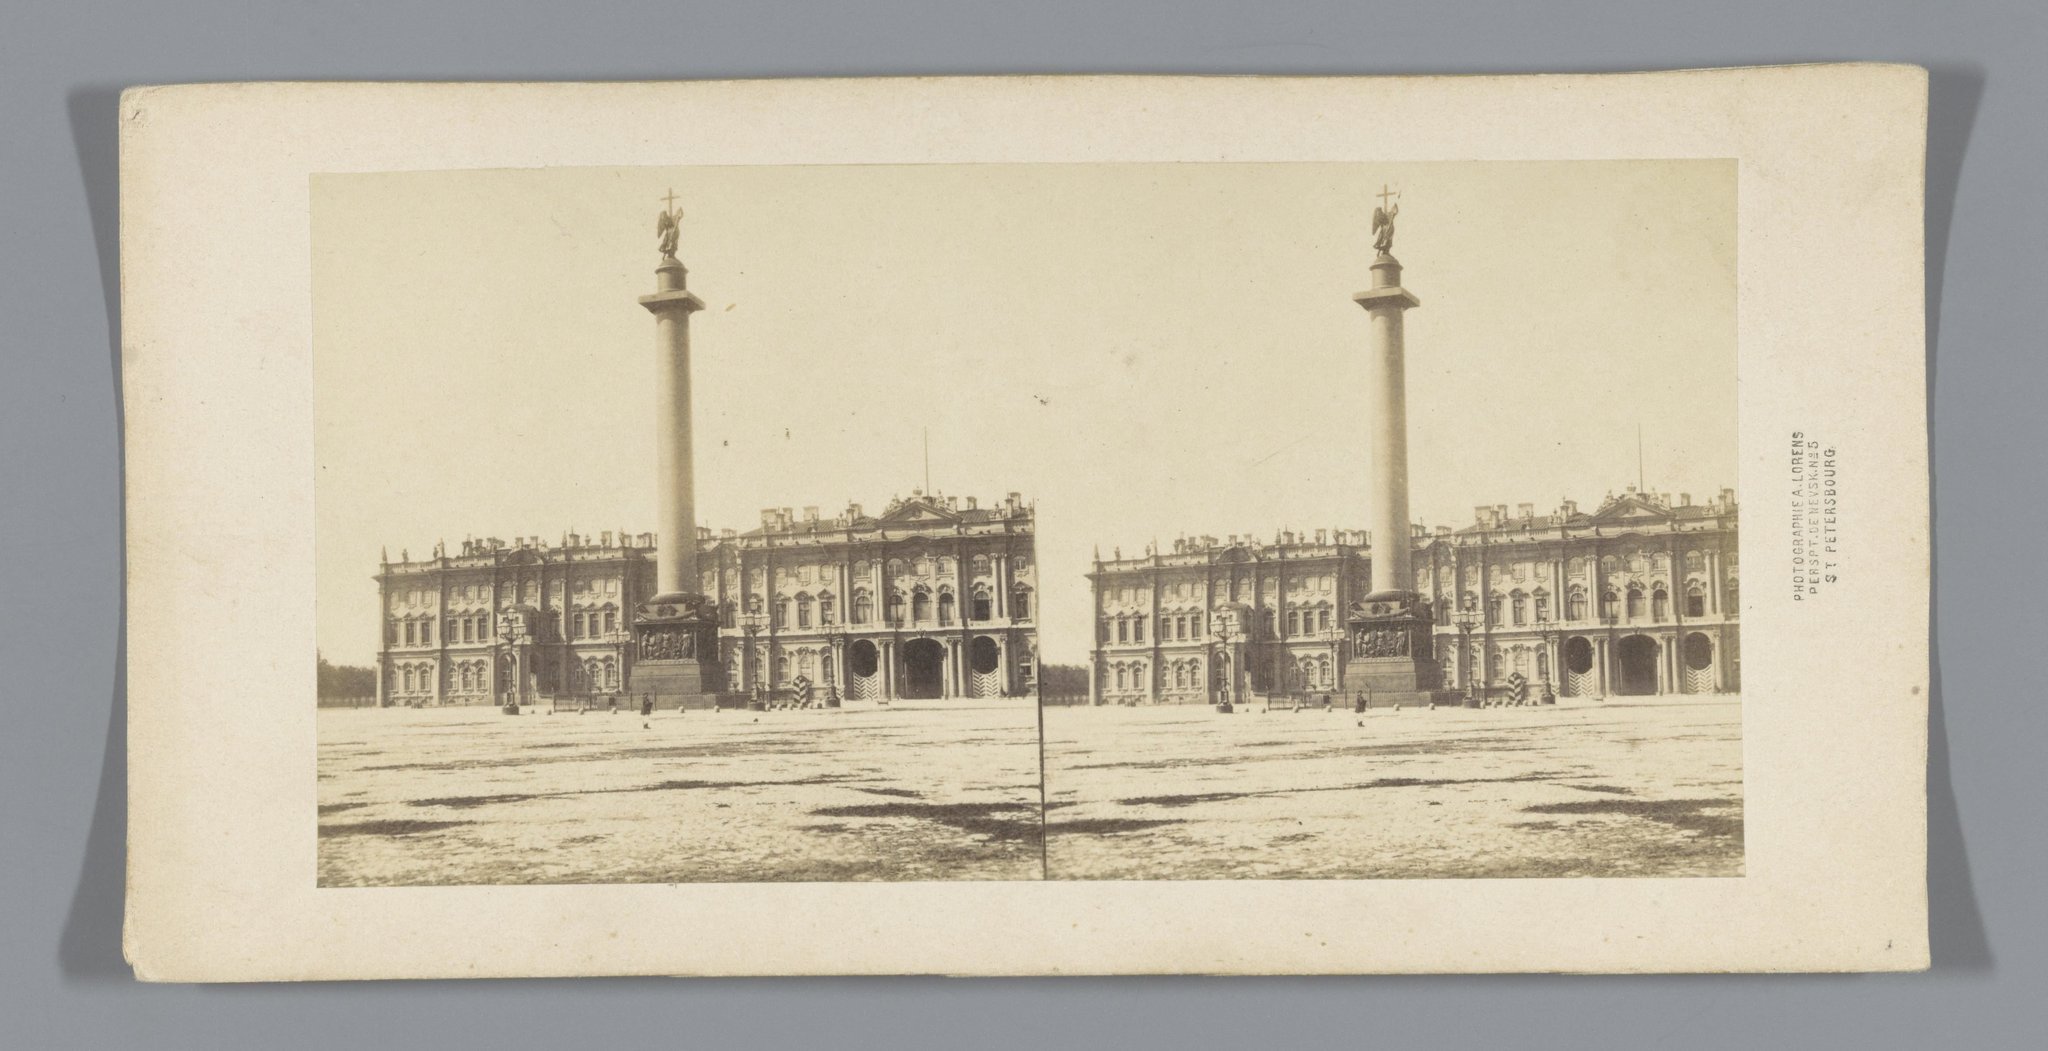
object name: stereograph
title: Gezicht op het Winterpaleis en de Alexander-obelisk in Sint-Petersburg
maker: alfred lorens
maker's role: fotograaf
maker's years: 1830-1896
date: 1860-1880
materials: cardboard, photographic support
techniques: albumen print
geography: sint-petersburg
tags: palace, monument, statue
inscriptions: number: ‘6. 13.’, name: ‘PHOTOGRAPHIE A.LORENS PERSPT.DE NEVSK. NO 5 ST PETERSBOURG.’, inscription: ‘St. Petersburg. Winterpaleis en Zuil "Archangel"’